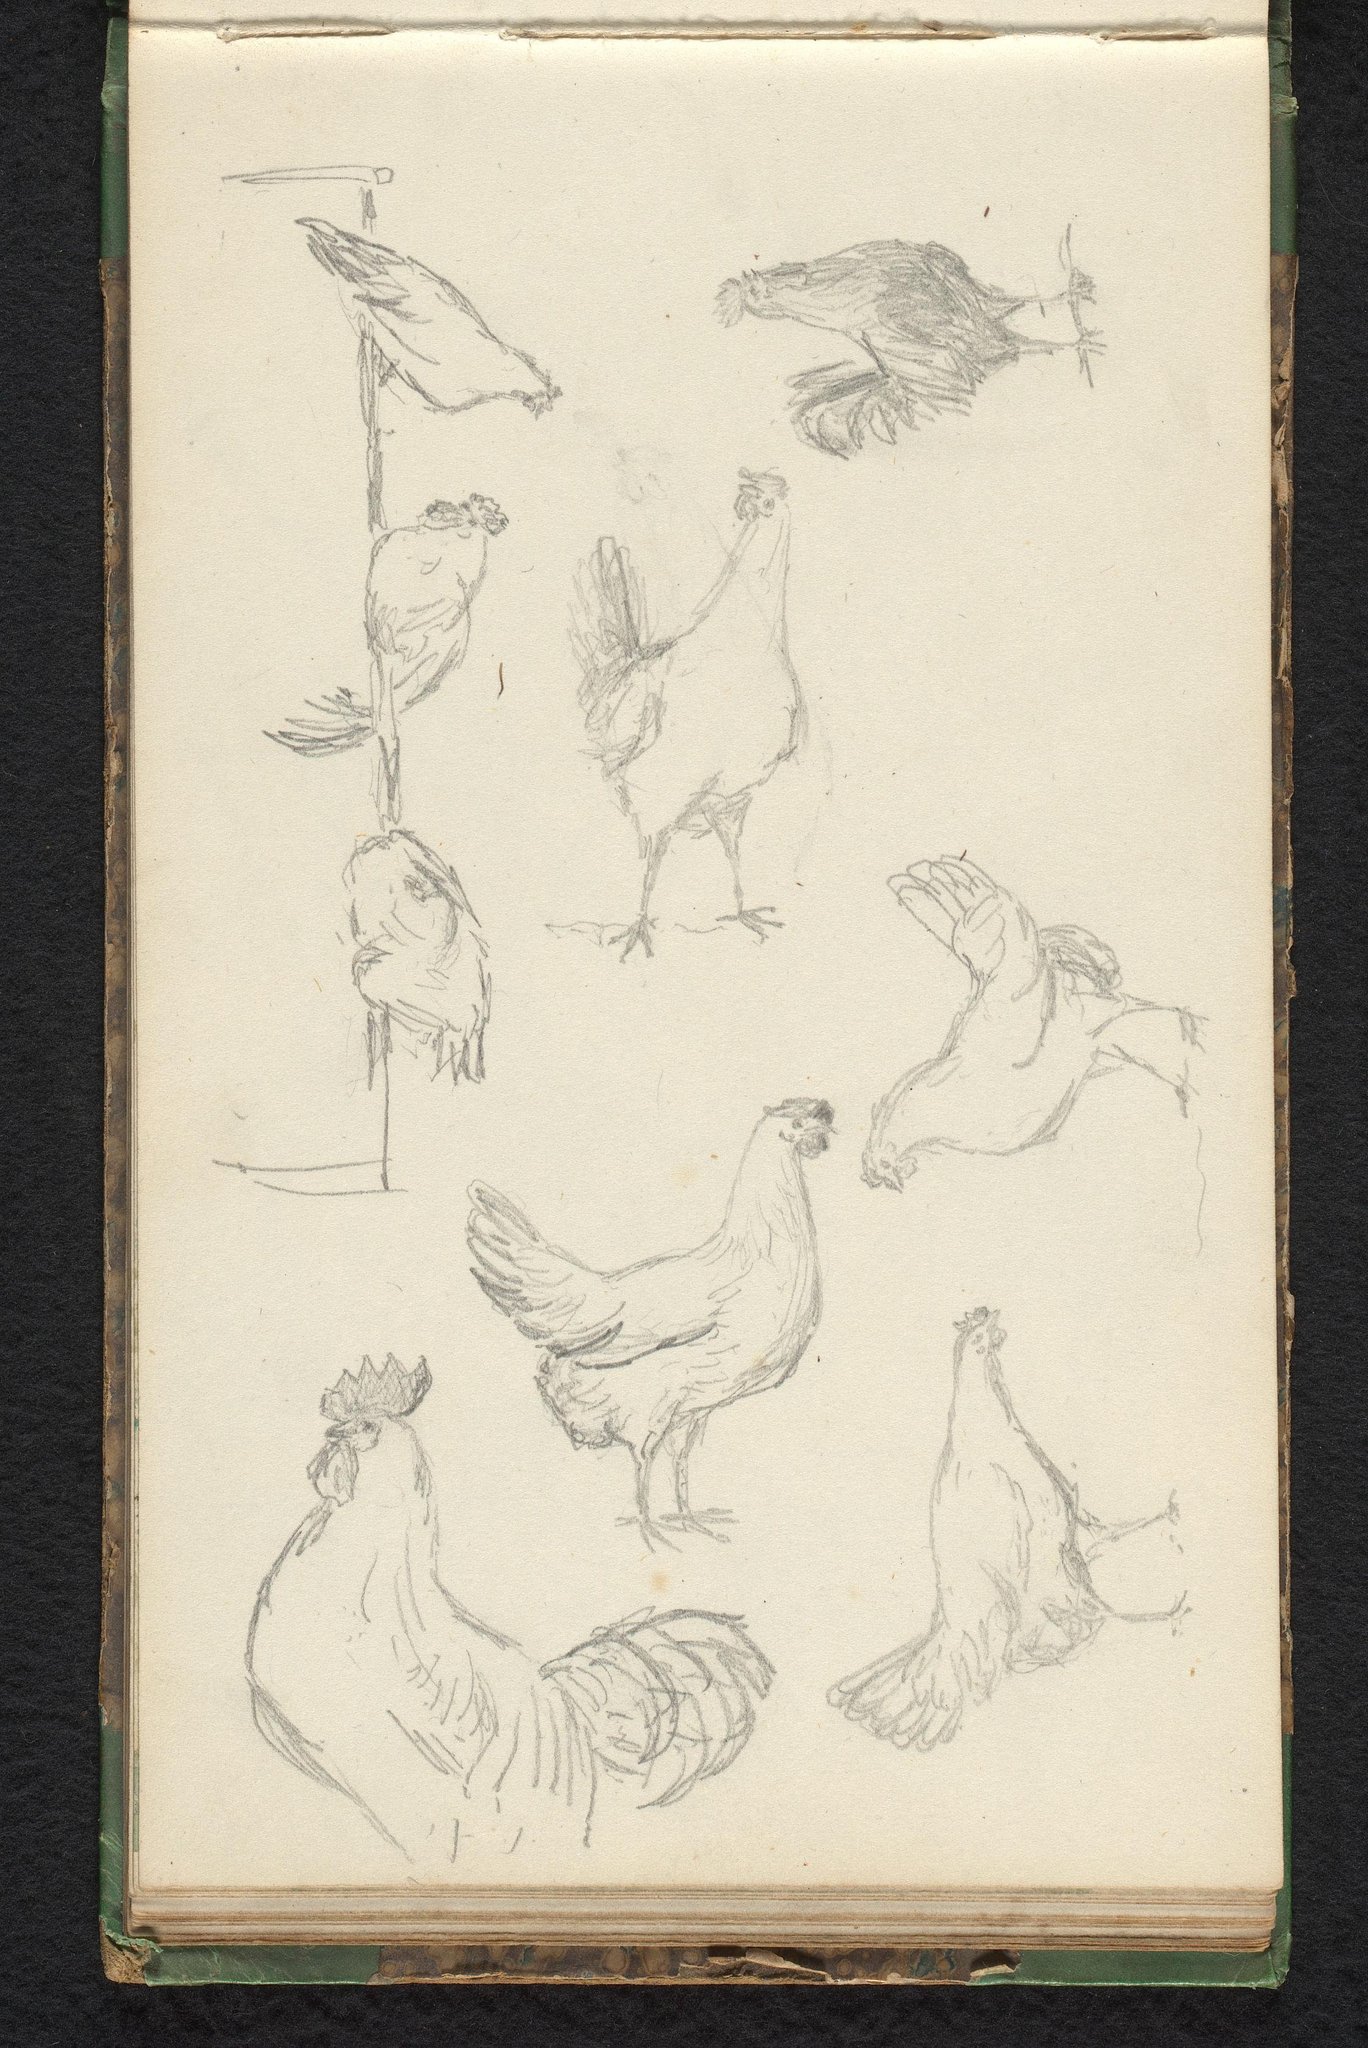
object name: sketchbook leaf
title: Kippen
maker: jan bedijs tom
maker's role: draughtsman, painter, print maker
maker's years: 1813-1894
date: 1823-1894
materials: paper, pencil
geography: the hague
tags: fowl (cock, hen, chicken, etc.)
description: Pagina 16 verso uit een schetsboek met 61 bladen.